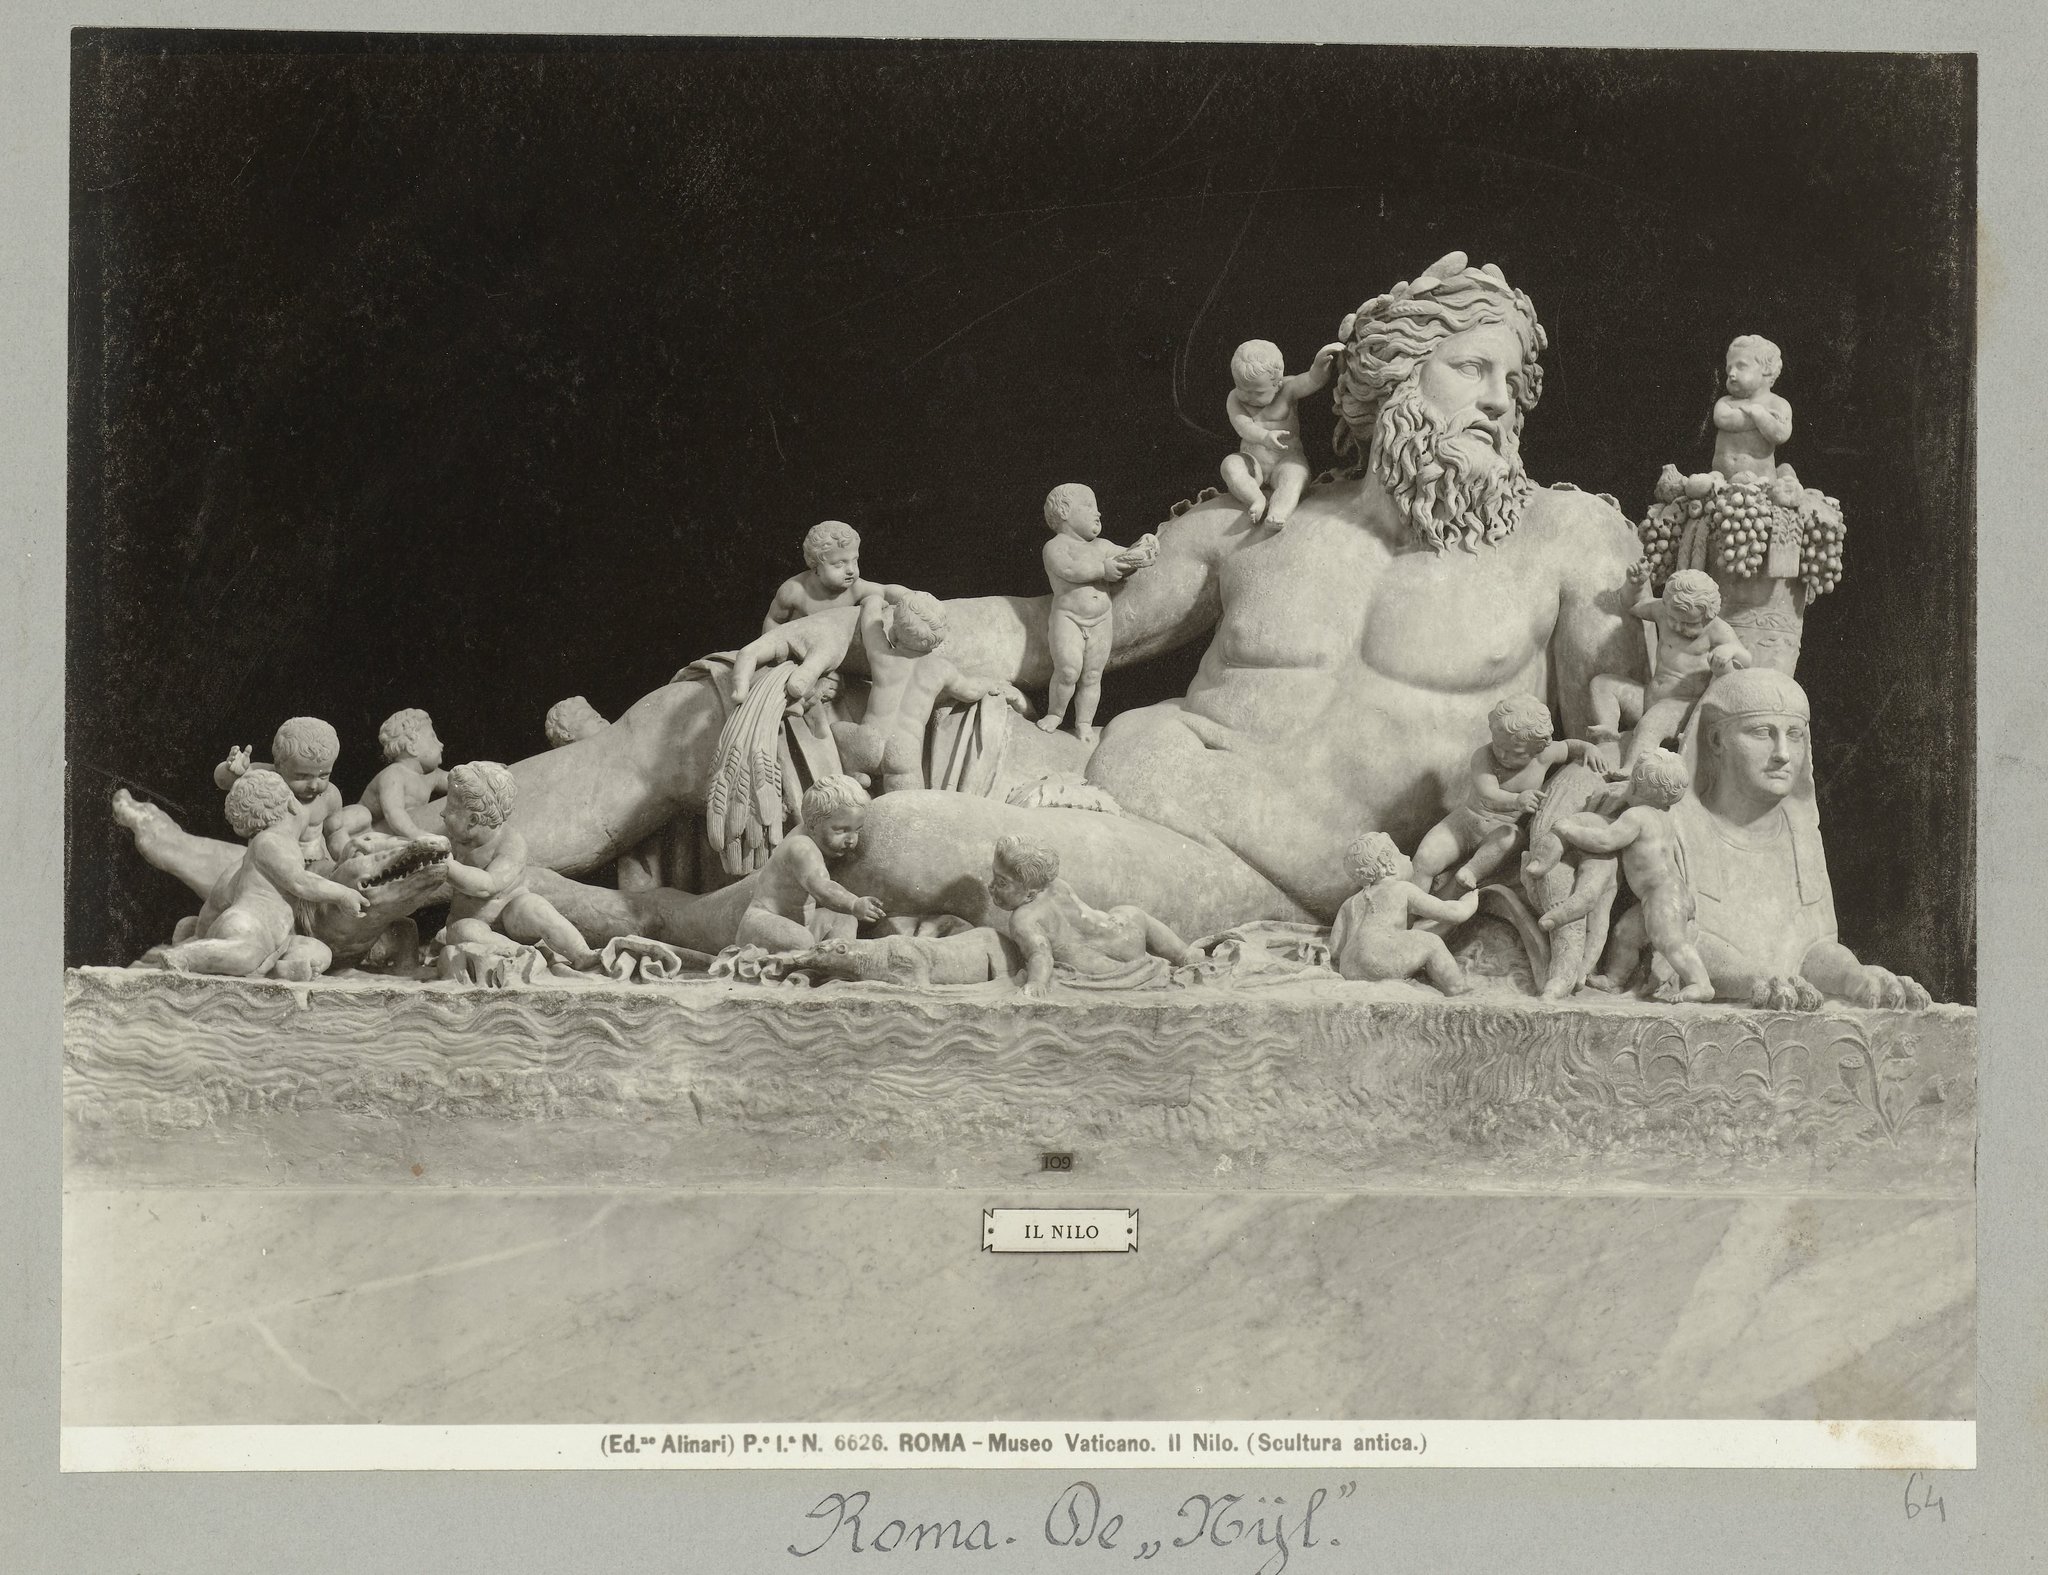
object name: photograph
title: P.I.N. 6626 Roma - Museo Vaticano. Il Nilo (Scultura Antica)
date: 1893-1903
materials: cardboard, photographic support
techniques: albumen print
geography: rome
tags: rome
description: Een beeld van de rivier De Nijl in de vorm van een man omringd door kleine figuren en een sfinx.